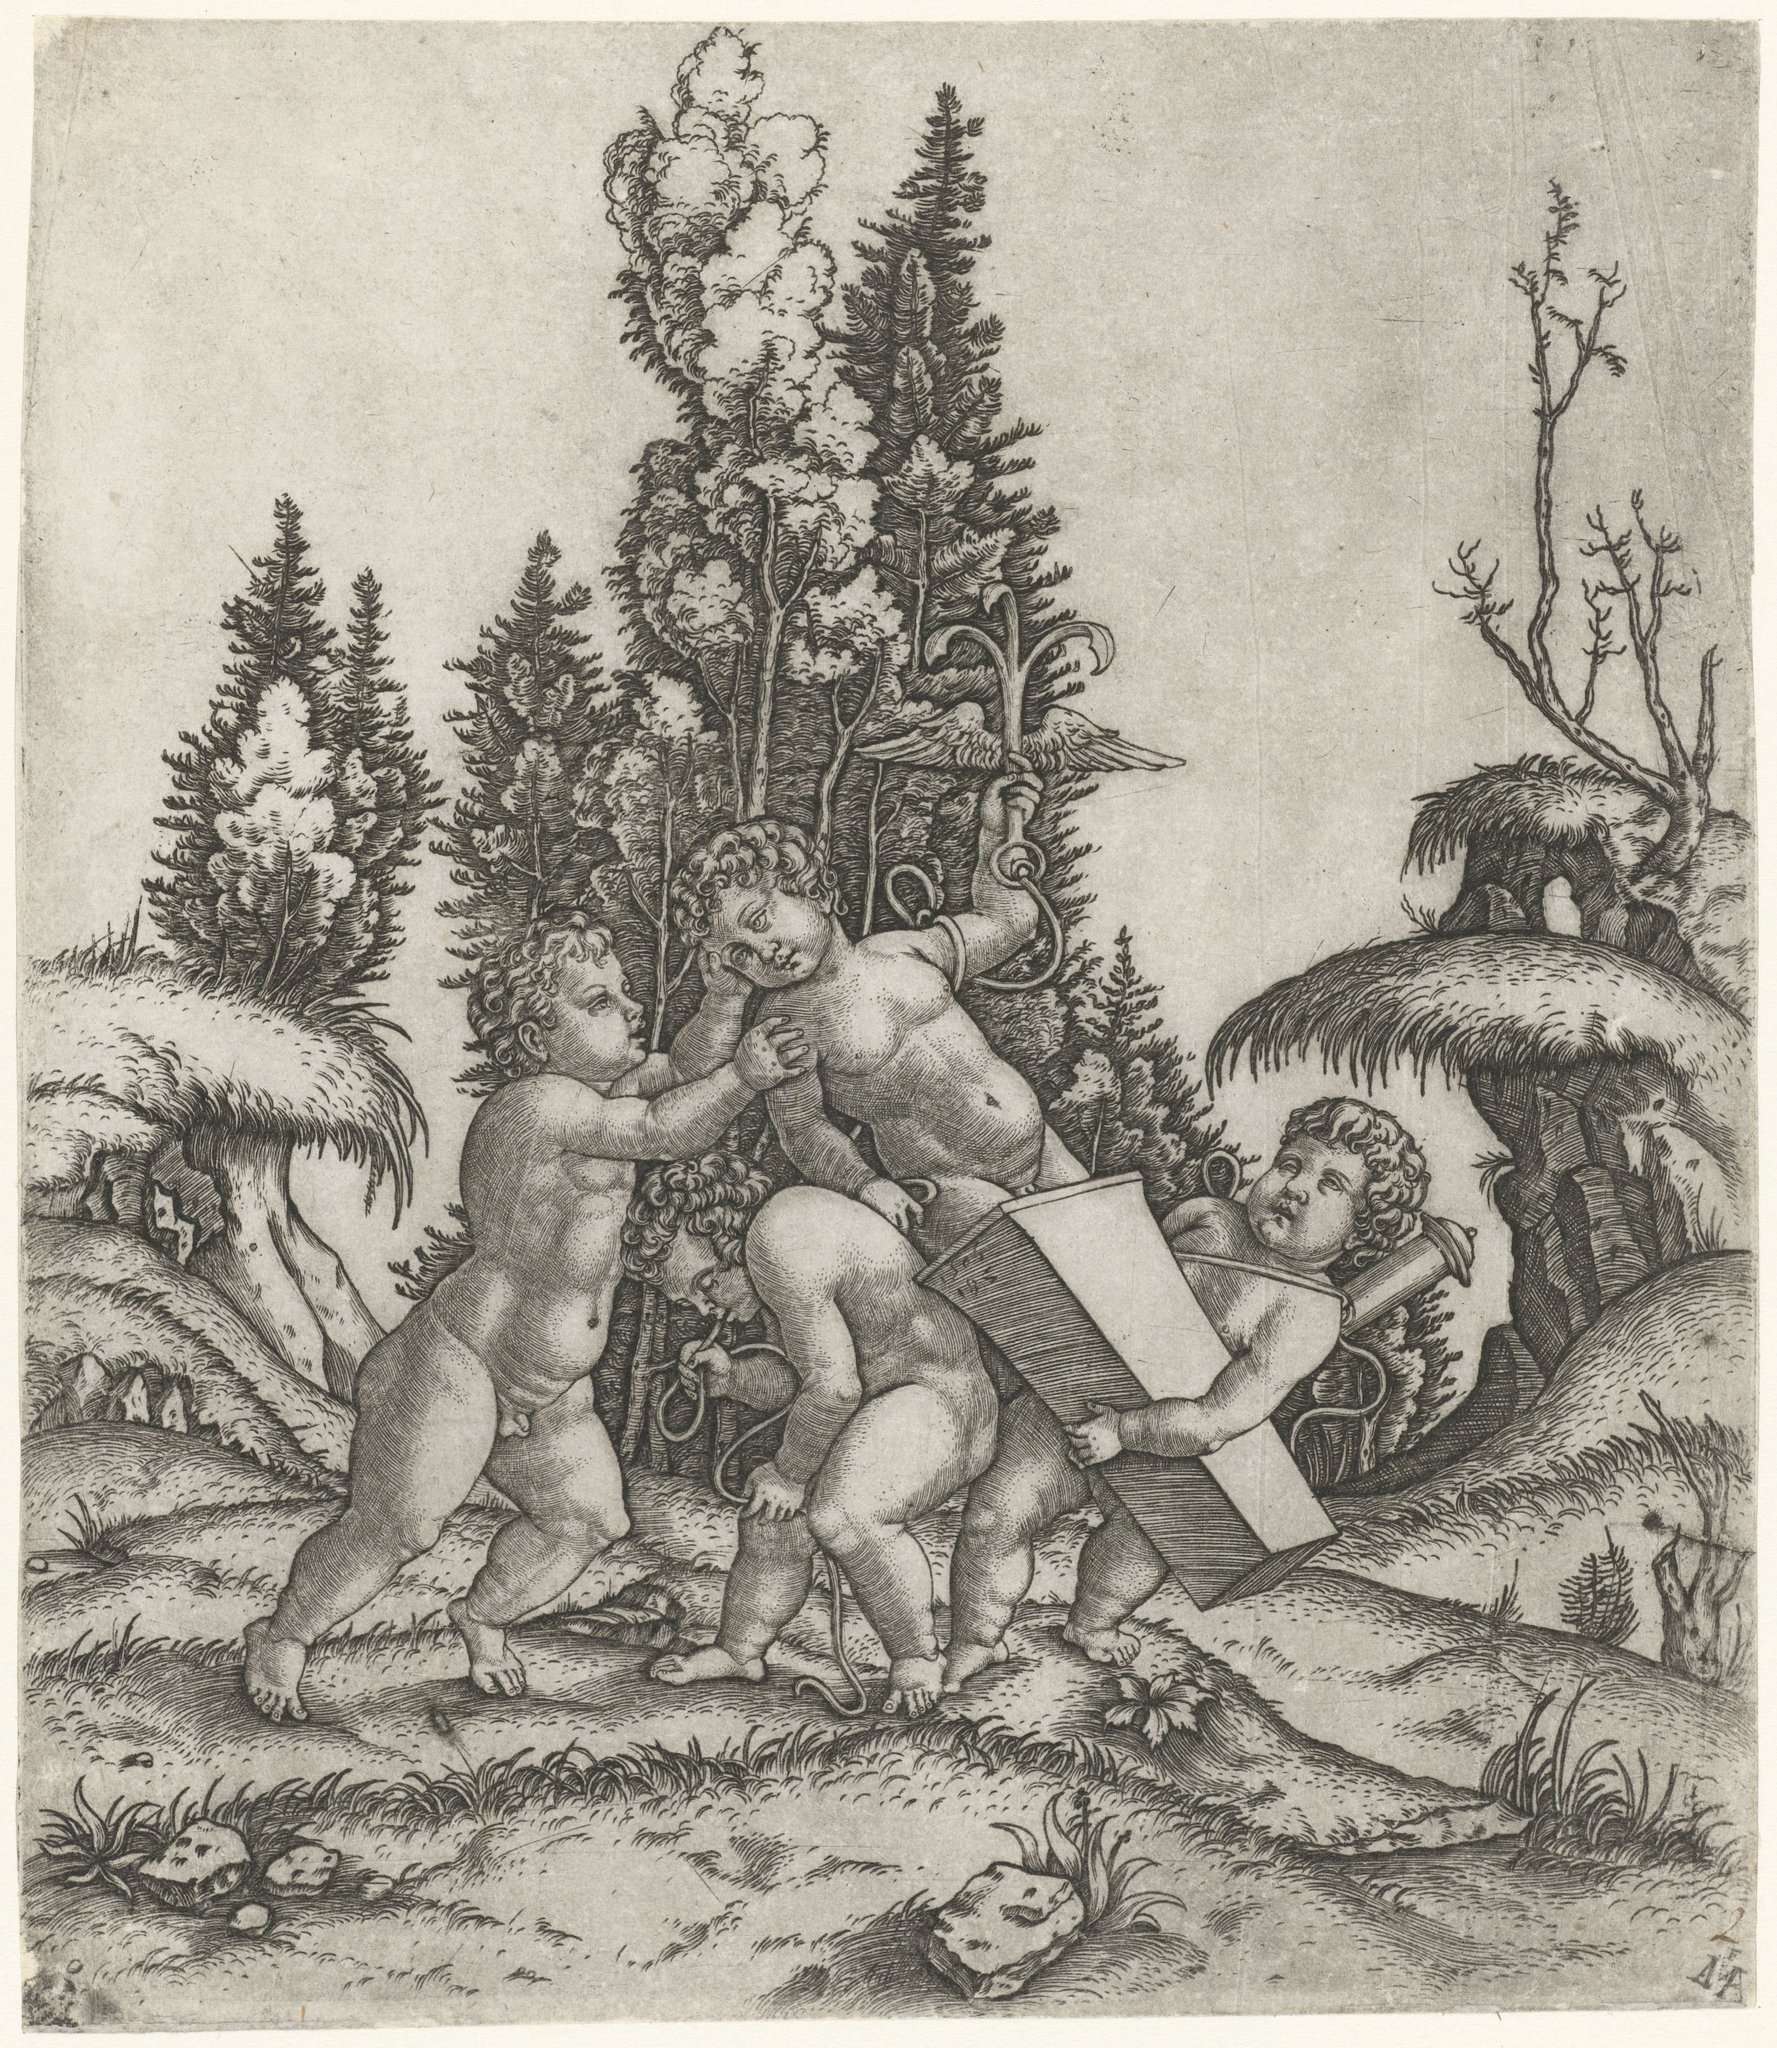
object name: print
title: Amor en twee putti of kinderen dragen beeld van putti met gevleugeld anker op sokkel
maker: marcantonio raimondi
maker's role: print maker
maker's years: 1470-1534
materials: paper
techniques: engraving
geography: italy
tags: (story of) cupid, amor (eros), cupids: 'amores', 'amoretti', 'putti'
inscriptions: inscription: ‘B 28 f 39-41’, collector's mark: Lugt 10, collector's mark: Lugt 11